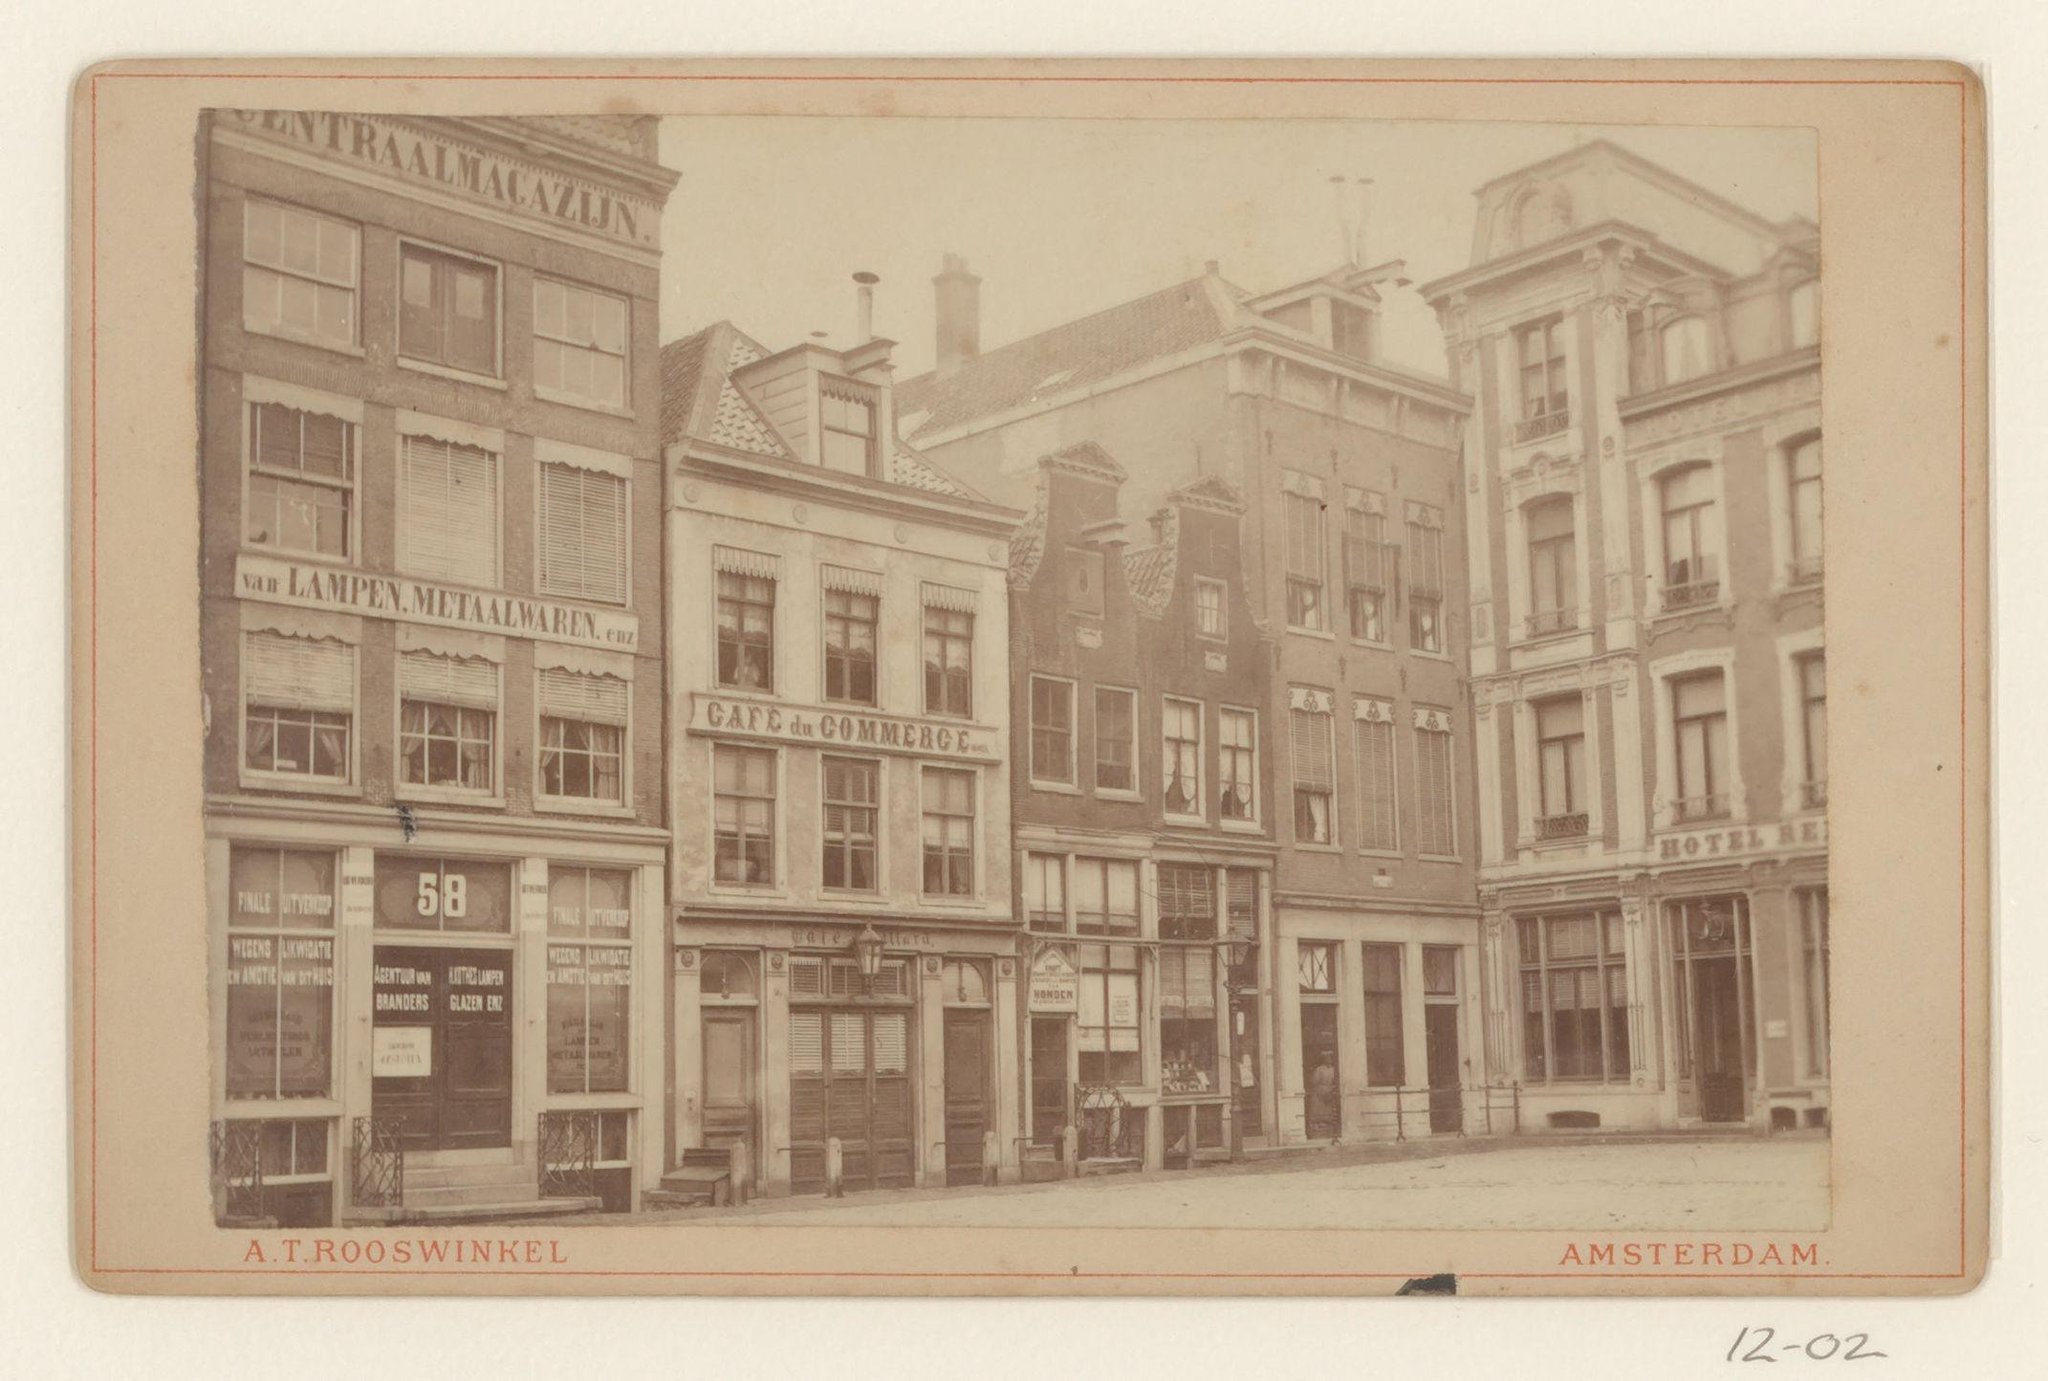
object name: cabinet photograph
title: Gezicht op het Rembrandtplein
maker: andreas theodorus rooswinkel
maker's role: fotograaf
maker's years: 1838-1909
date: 1876-1906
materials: cardboard, paper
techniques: albumen print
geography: amsterdam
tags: square, place, circus, etc., city-view in general; 'veduta', façade (of house or building)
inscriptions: collector's mark: ‘12,2’ Lugt 1641b, inscription: ‘Rembrandtsplein 46.’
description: Onderwerpsrubriek binnen de Atlas Amsterdam: Rembrandtplein (Botermarkt), Roeterseiland.